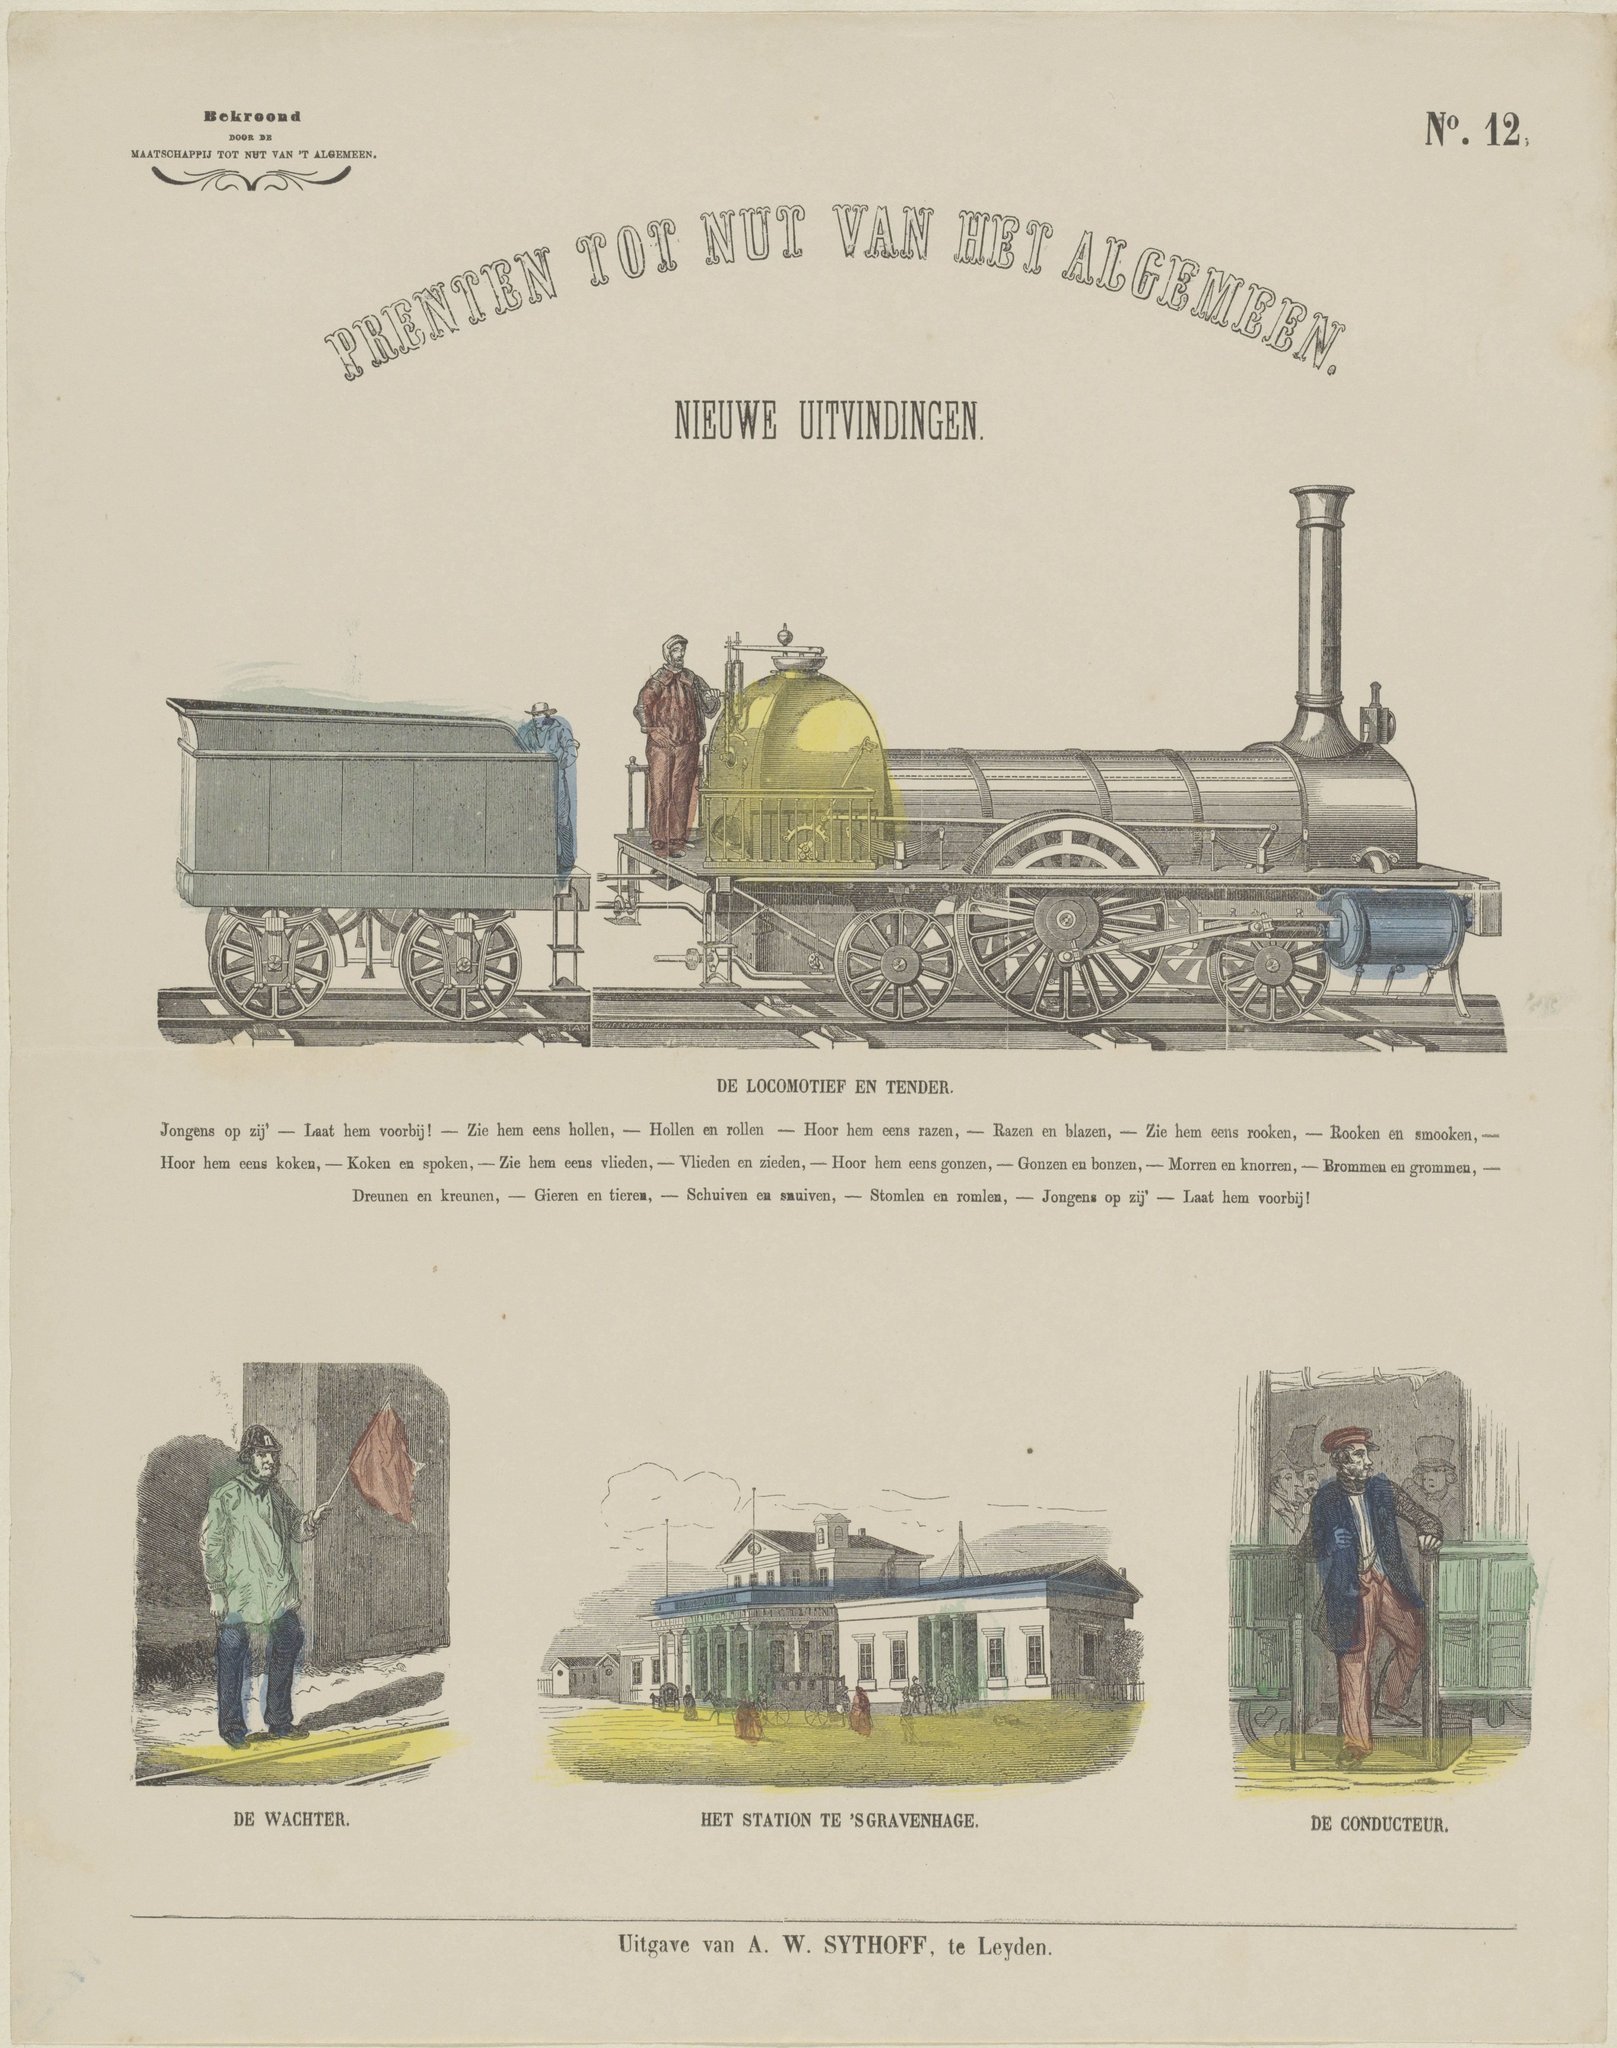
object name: popular print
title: Nieuwe uitvindingen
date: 1861-1929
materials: paper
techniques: colour, letterpress printing, engraving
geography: europe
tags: station; shelter (railway, tramway), steam locomotive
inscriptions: collector's mark: Lugt 2760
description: Blad met 4 voorstellingen van een locomotief, een wachter, het station van Den Haag en een conducteur. Onder elke afbeelding een titel. Onder de bovenste afbeelding een vers. Genummerd rechtsboven: No. 12. Linksboven: Bekroond door de Maatschappij tot Nut van 't Algemeen.